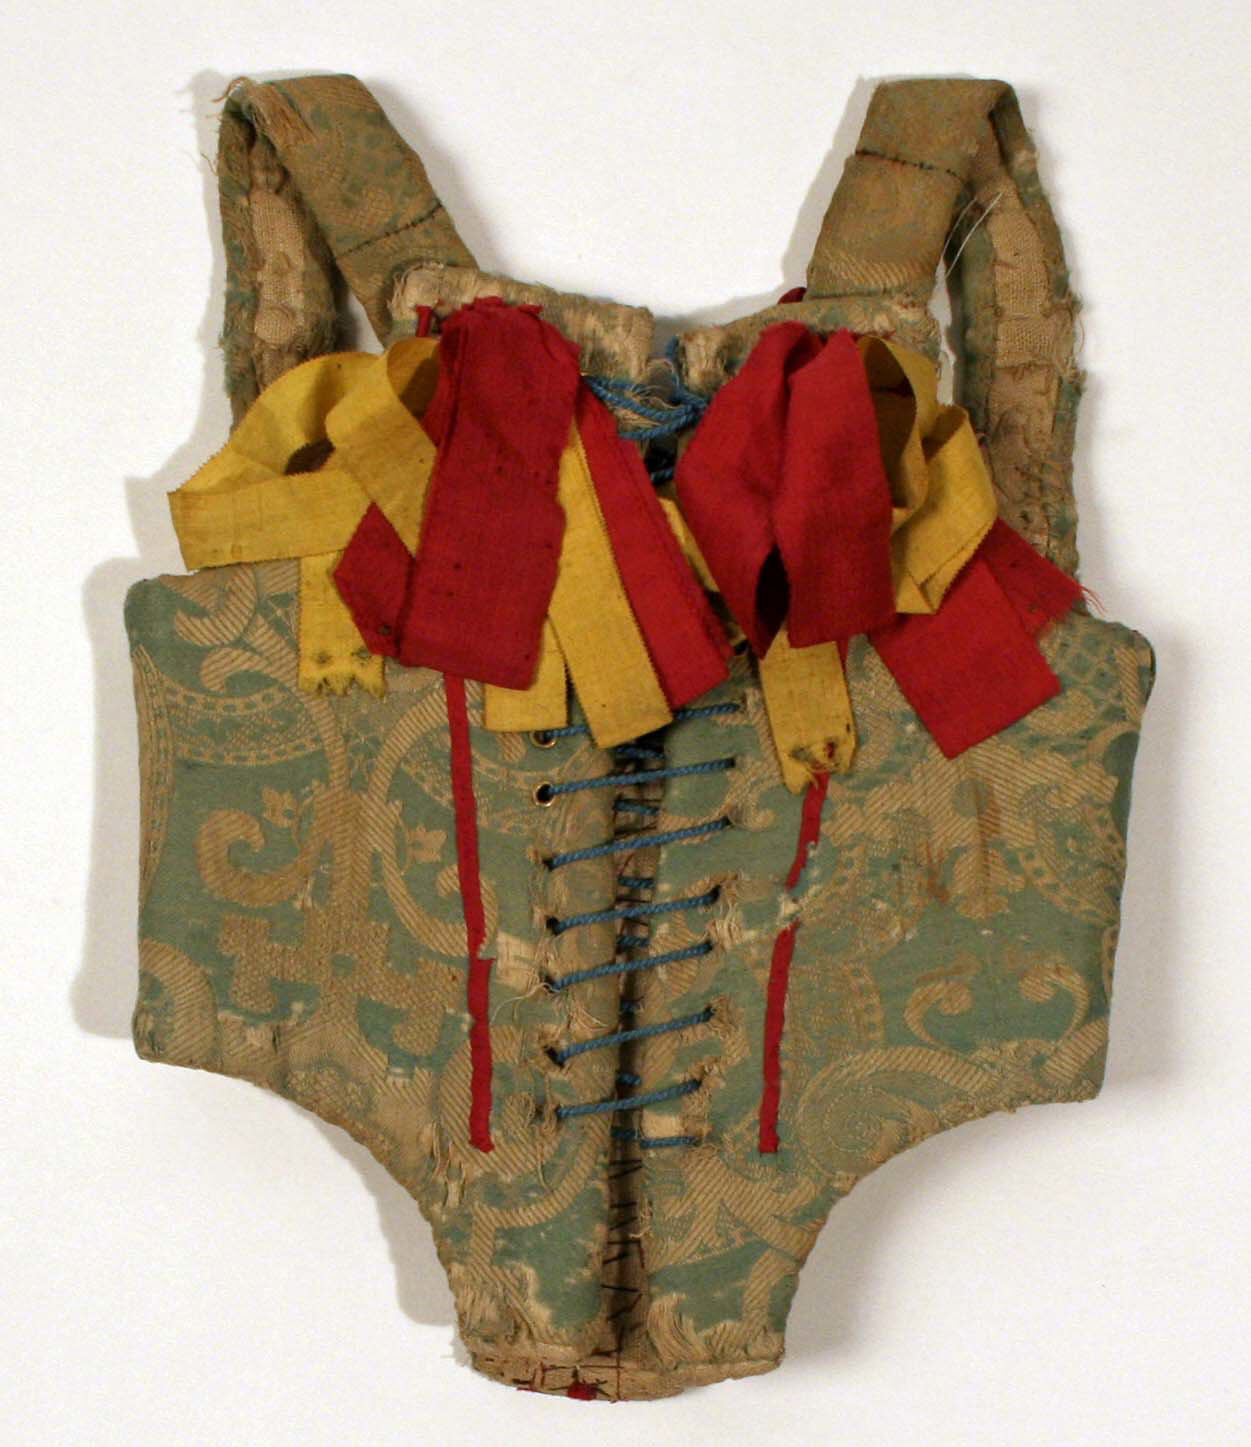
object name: corset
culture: spanish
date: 1700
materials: wool